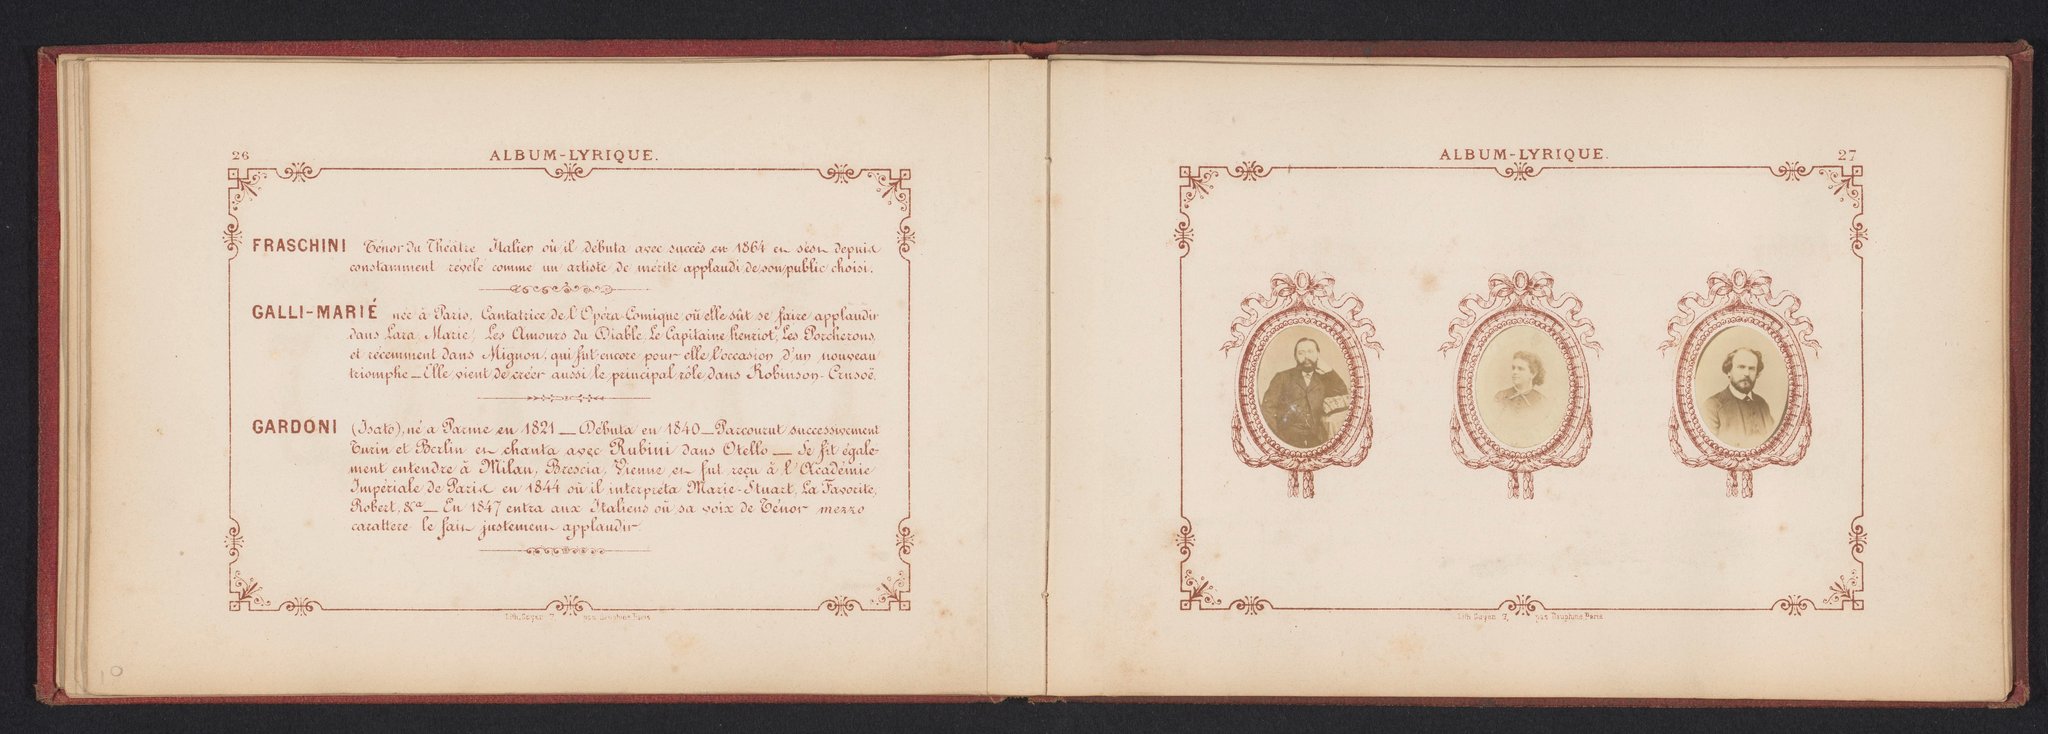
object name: page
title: Drie fotoreproducties, voorstellende portretten van Gaetano Fraschini, Célestine Galli-Marié en Italo Gardoni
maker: antoine rené trinquart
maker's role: fotograaf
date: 1858-1868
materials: paper, photographic support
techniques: albumen print, printing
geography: france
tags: portrait of opera-singer